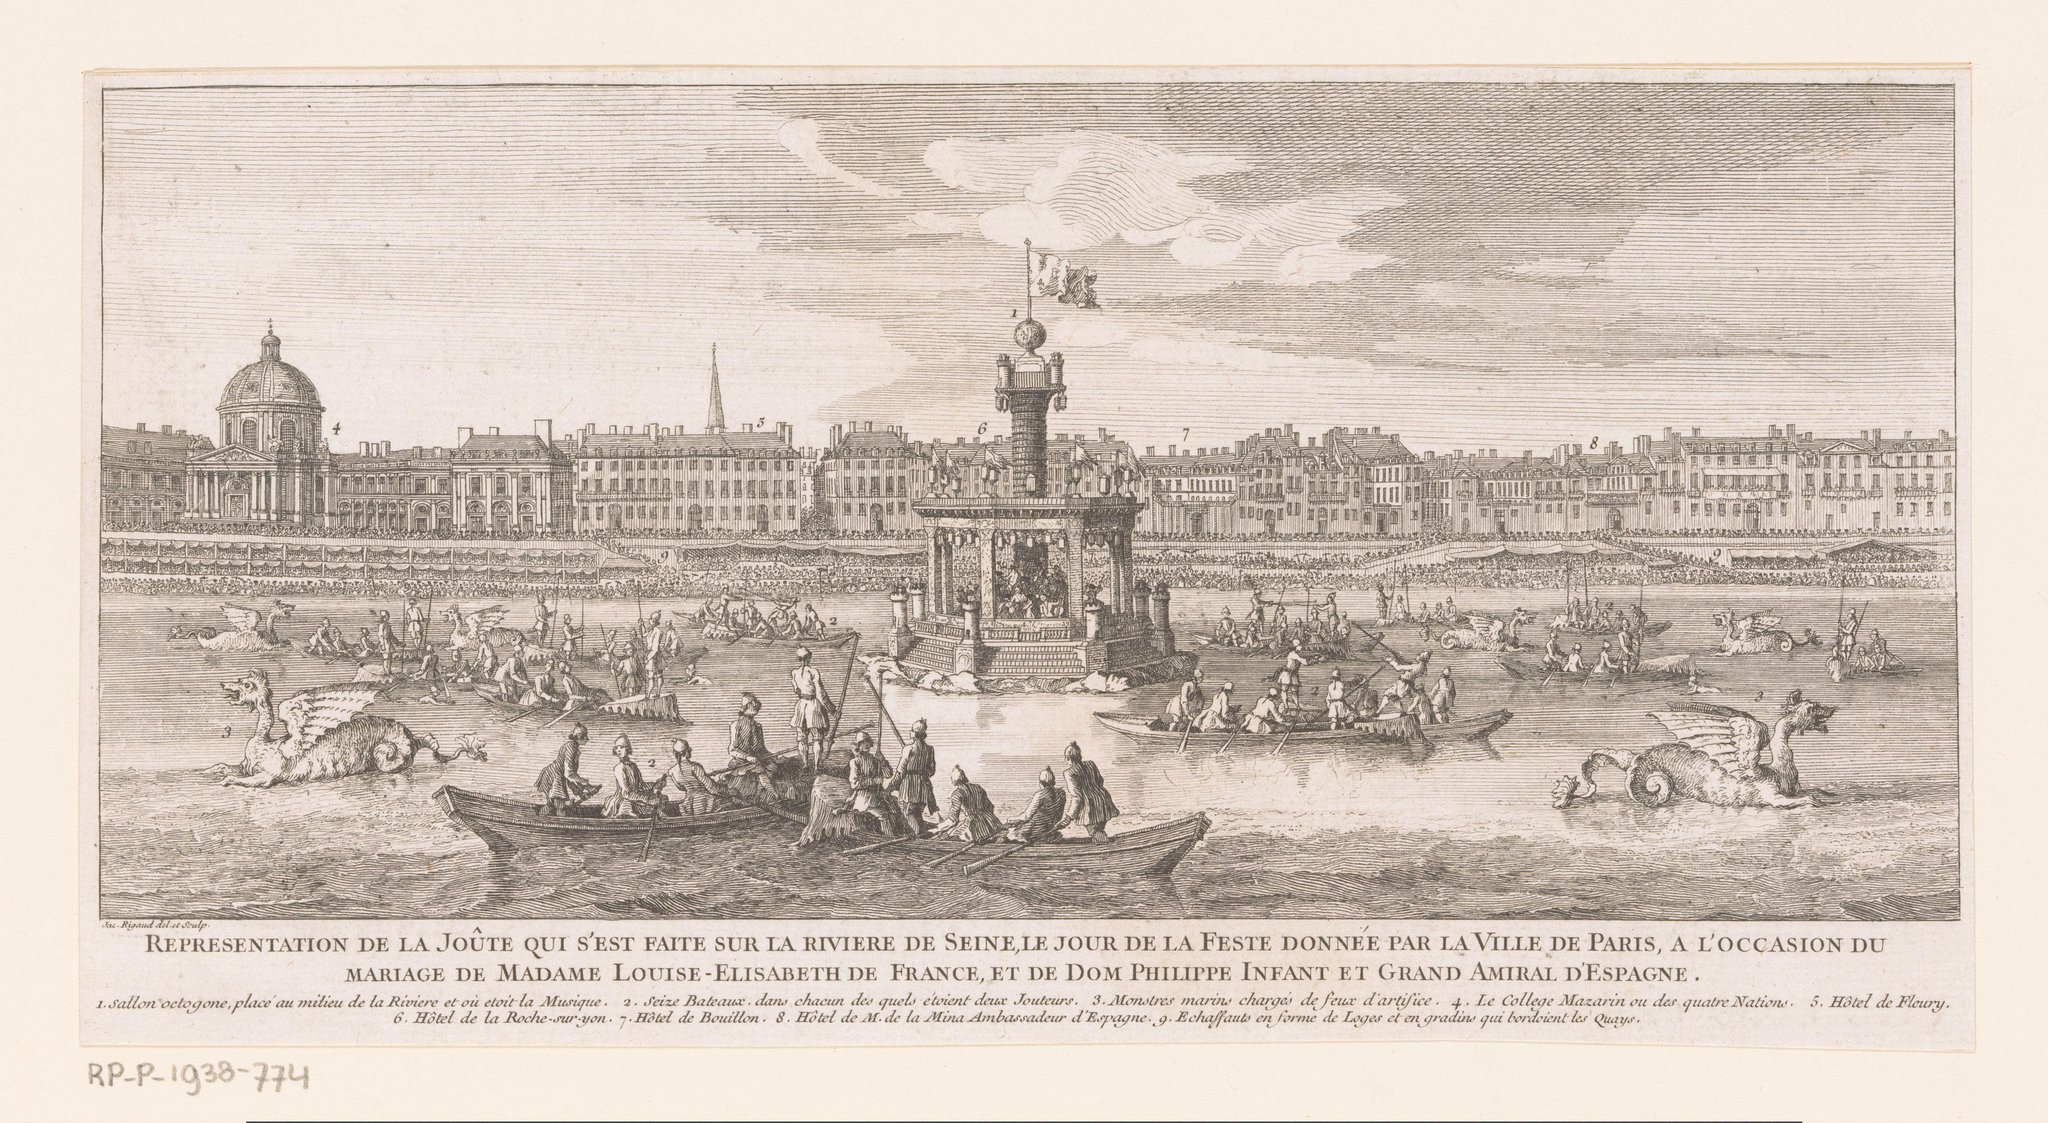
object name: print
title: Gezicht op feestelijkheden op de Seine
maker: jacques rigaud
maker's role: draughtsman, painter, print maker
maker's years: 1681-1754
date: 1686-1758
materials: paper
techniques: etching, letterpress printing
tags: public festivities - aa - festivities on the water, canals, waters (in city)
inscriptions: collector's mark: Lugt 2228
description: Spektakel met roeiboten en zeemonsters aangedreven door vuur, ter gelegenheid van het huwelijk van Louise Elisabeth van Frankrijk en Filips van Spanje.